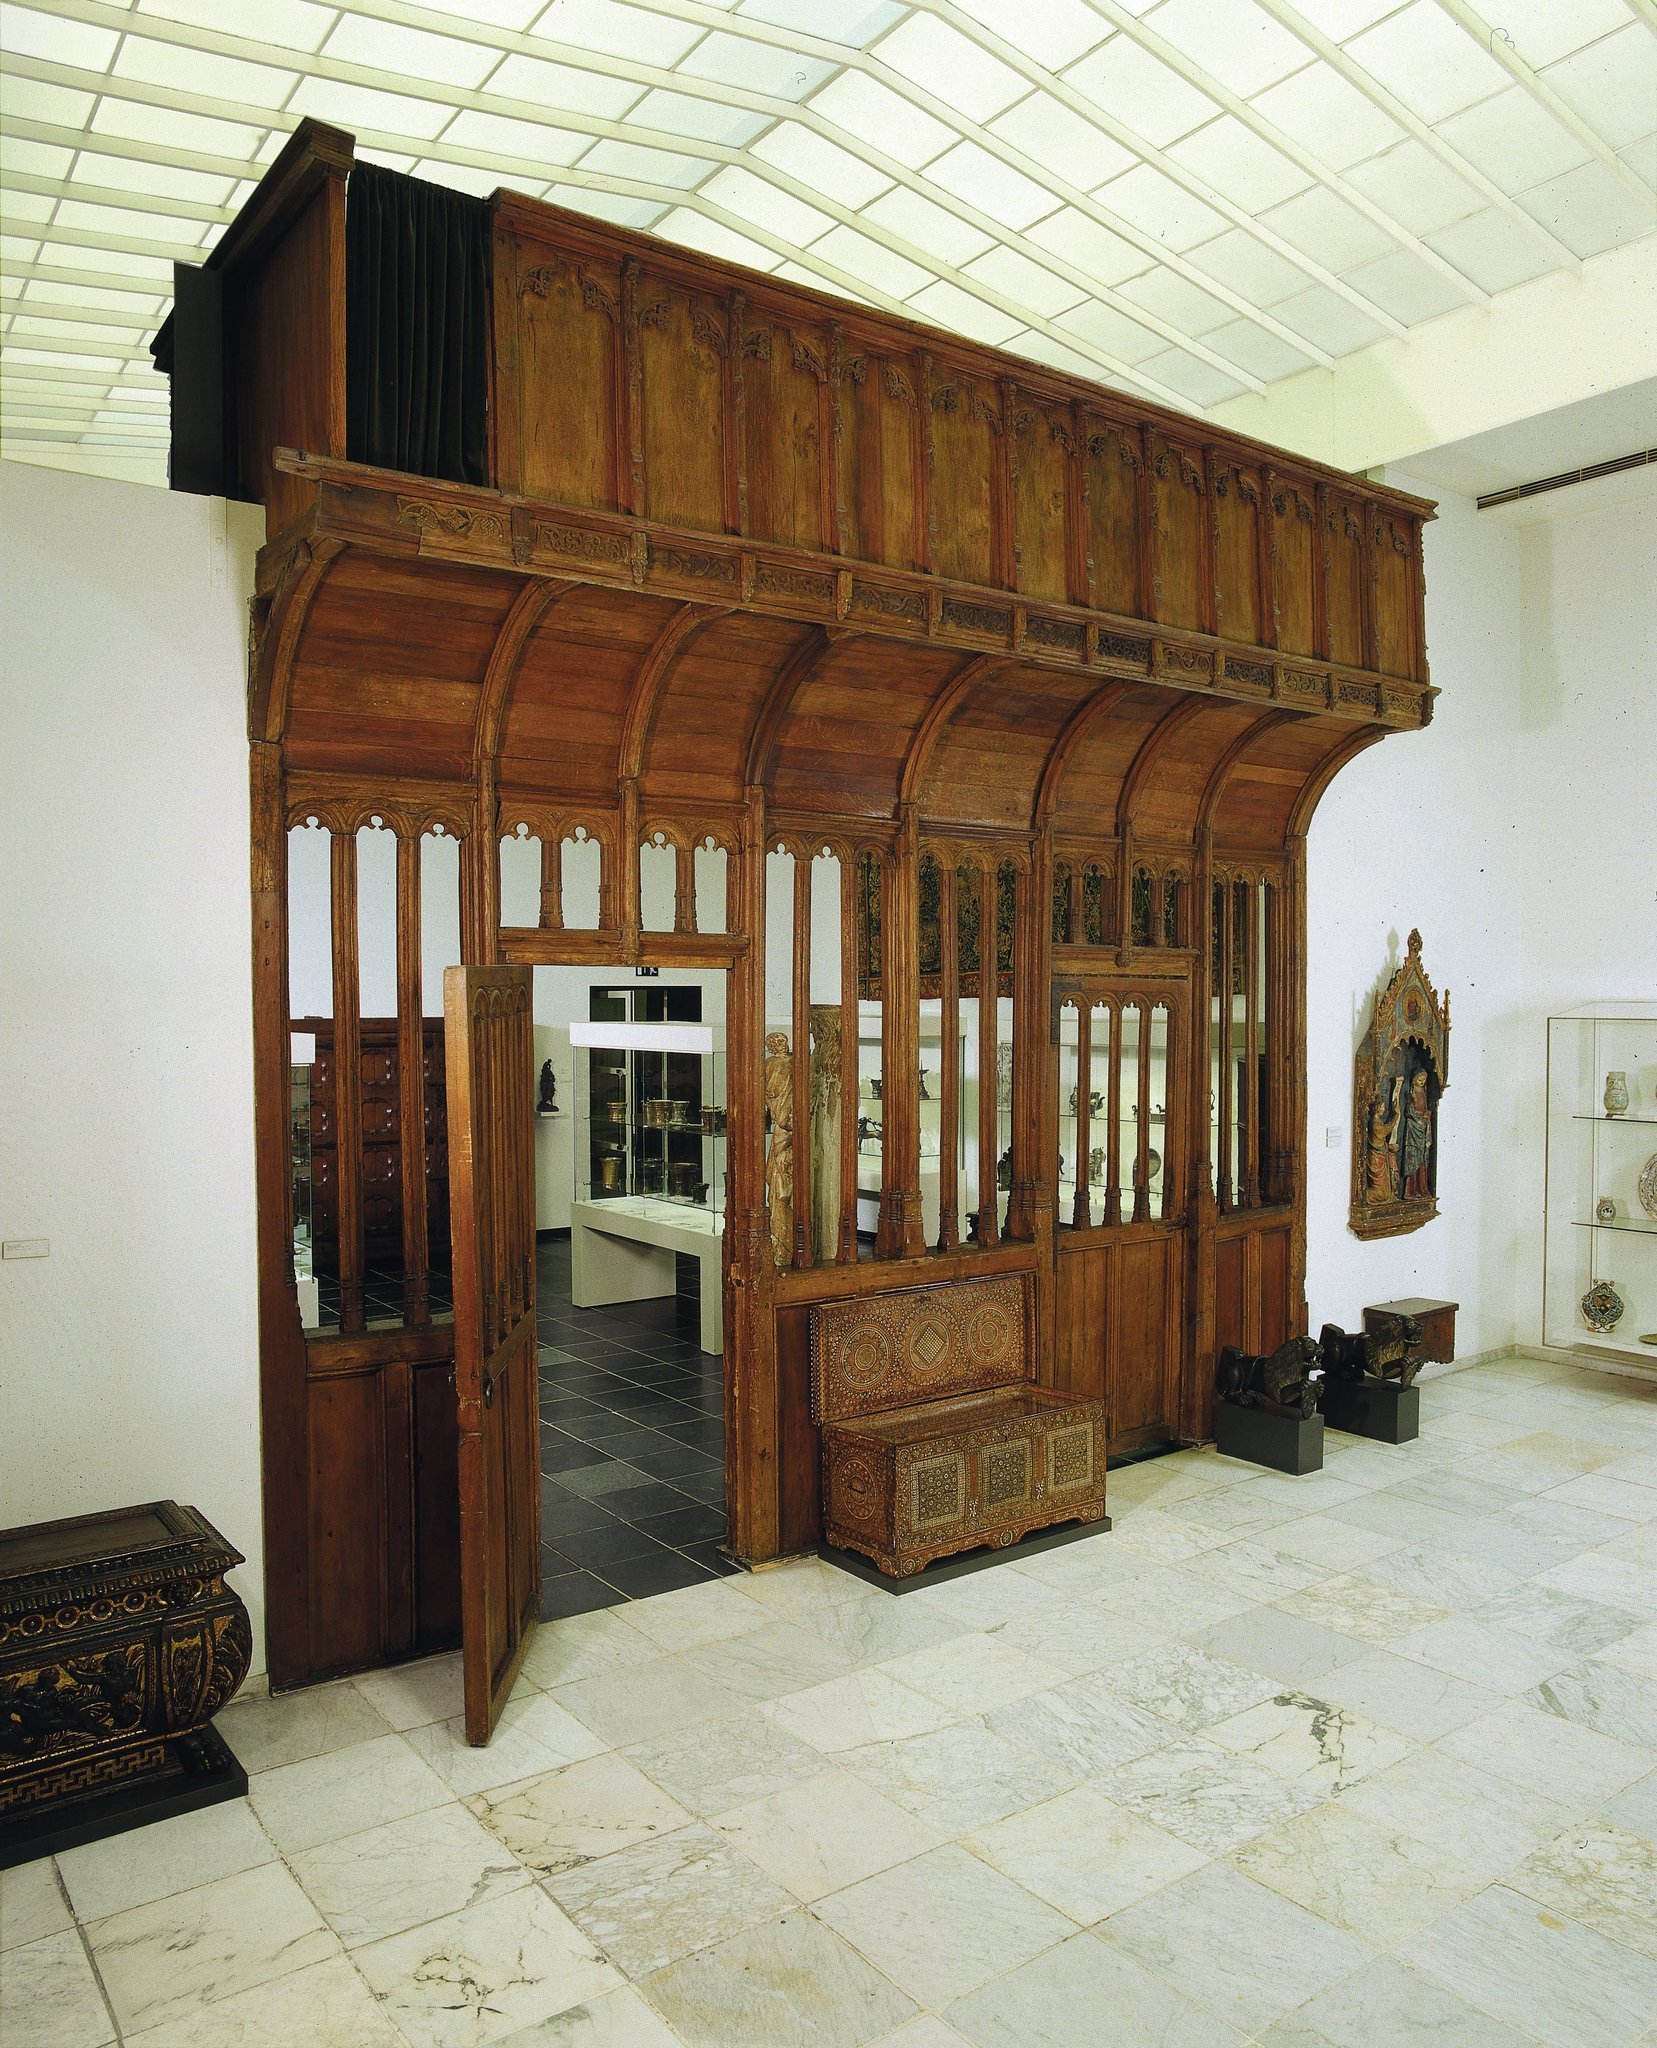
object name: furniture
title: Oksaal (koorafscheiding), afkomstig uit de kerk te Helvoirt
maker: Anonymous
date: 1500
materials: wood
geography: netherlands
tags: ornament ~ tracery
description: Choir-screen, from the church at Helvoirt. Oak. Netherlands, c. 1500.